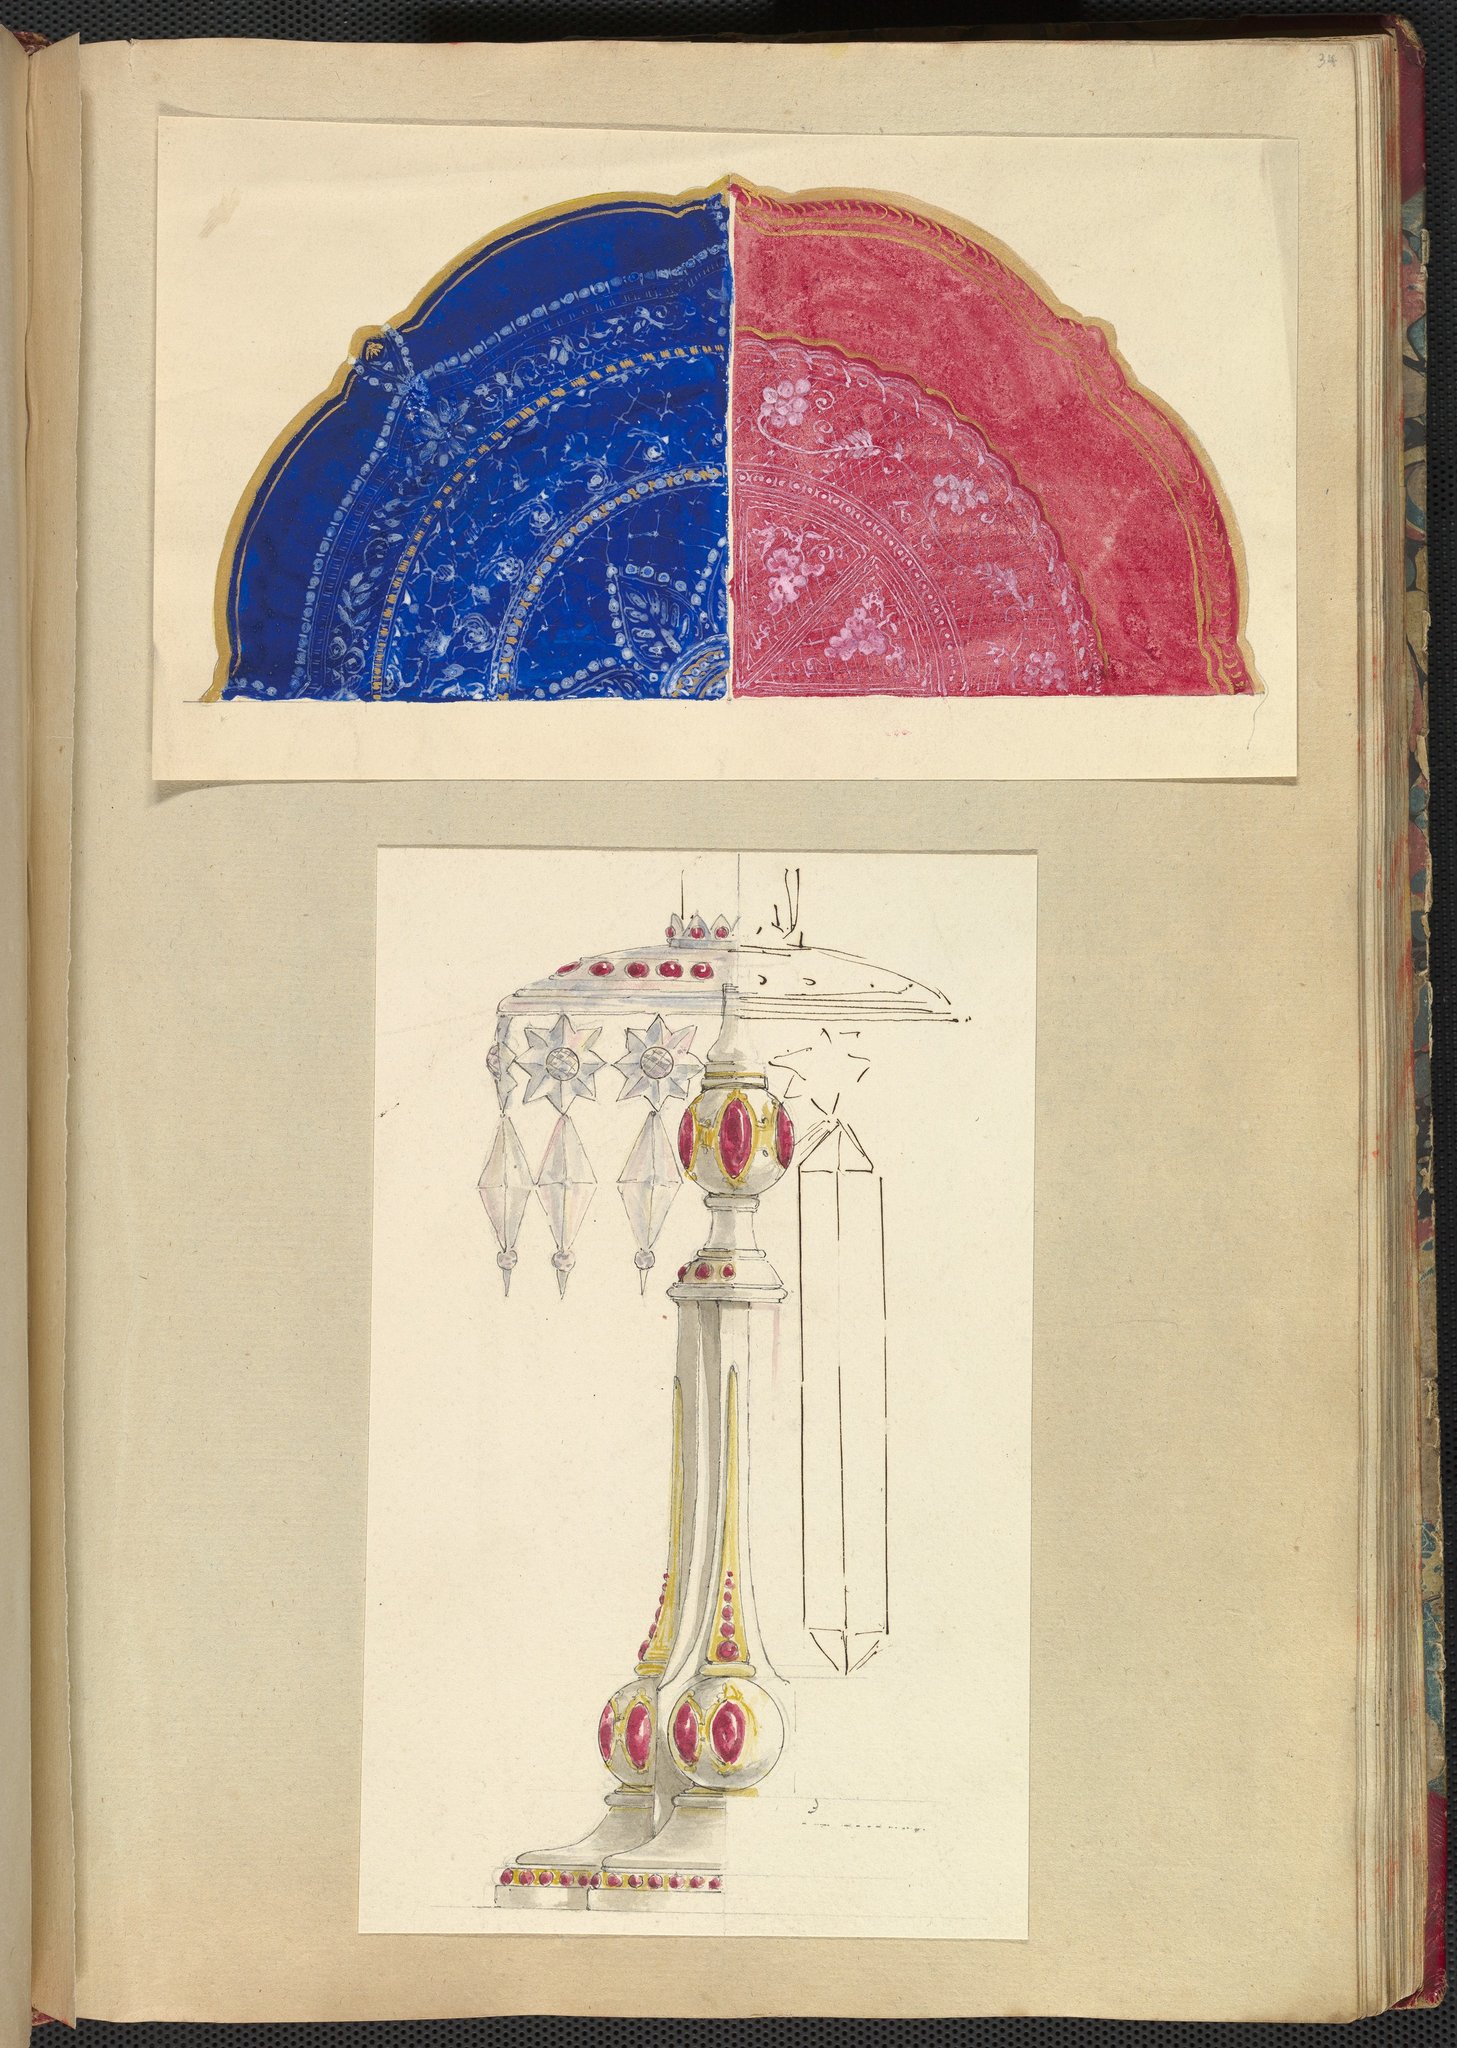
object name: drawing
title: Designs for Two Decorated Plates and a Candleholder with Cut Glass Drops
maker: alfred henry forrester [alfred crowquill]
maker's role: artist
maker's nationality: british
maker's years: 1804-1872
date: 1845-1855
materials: gouache, ink, watercolor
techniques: pen